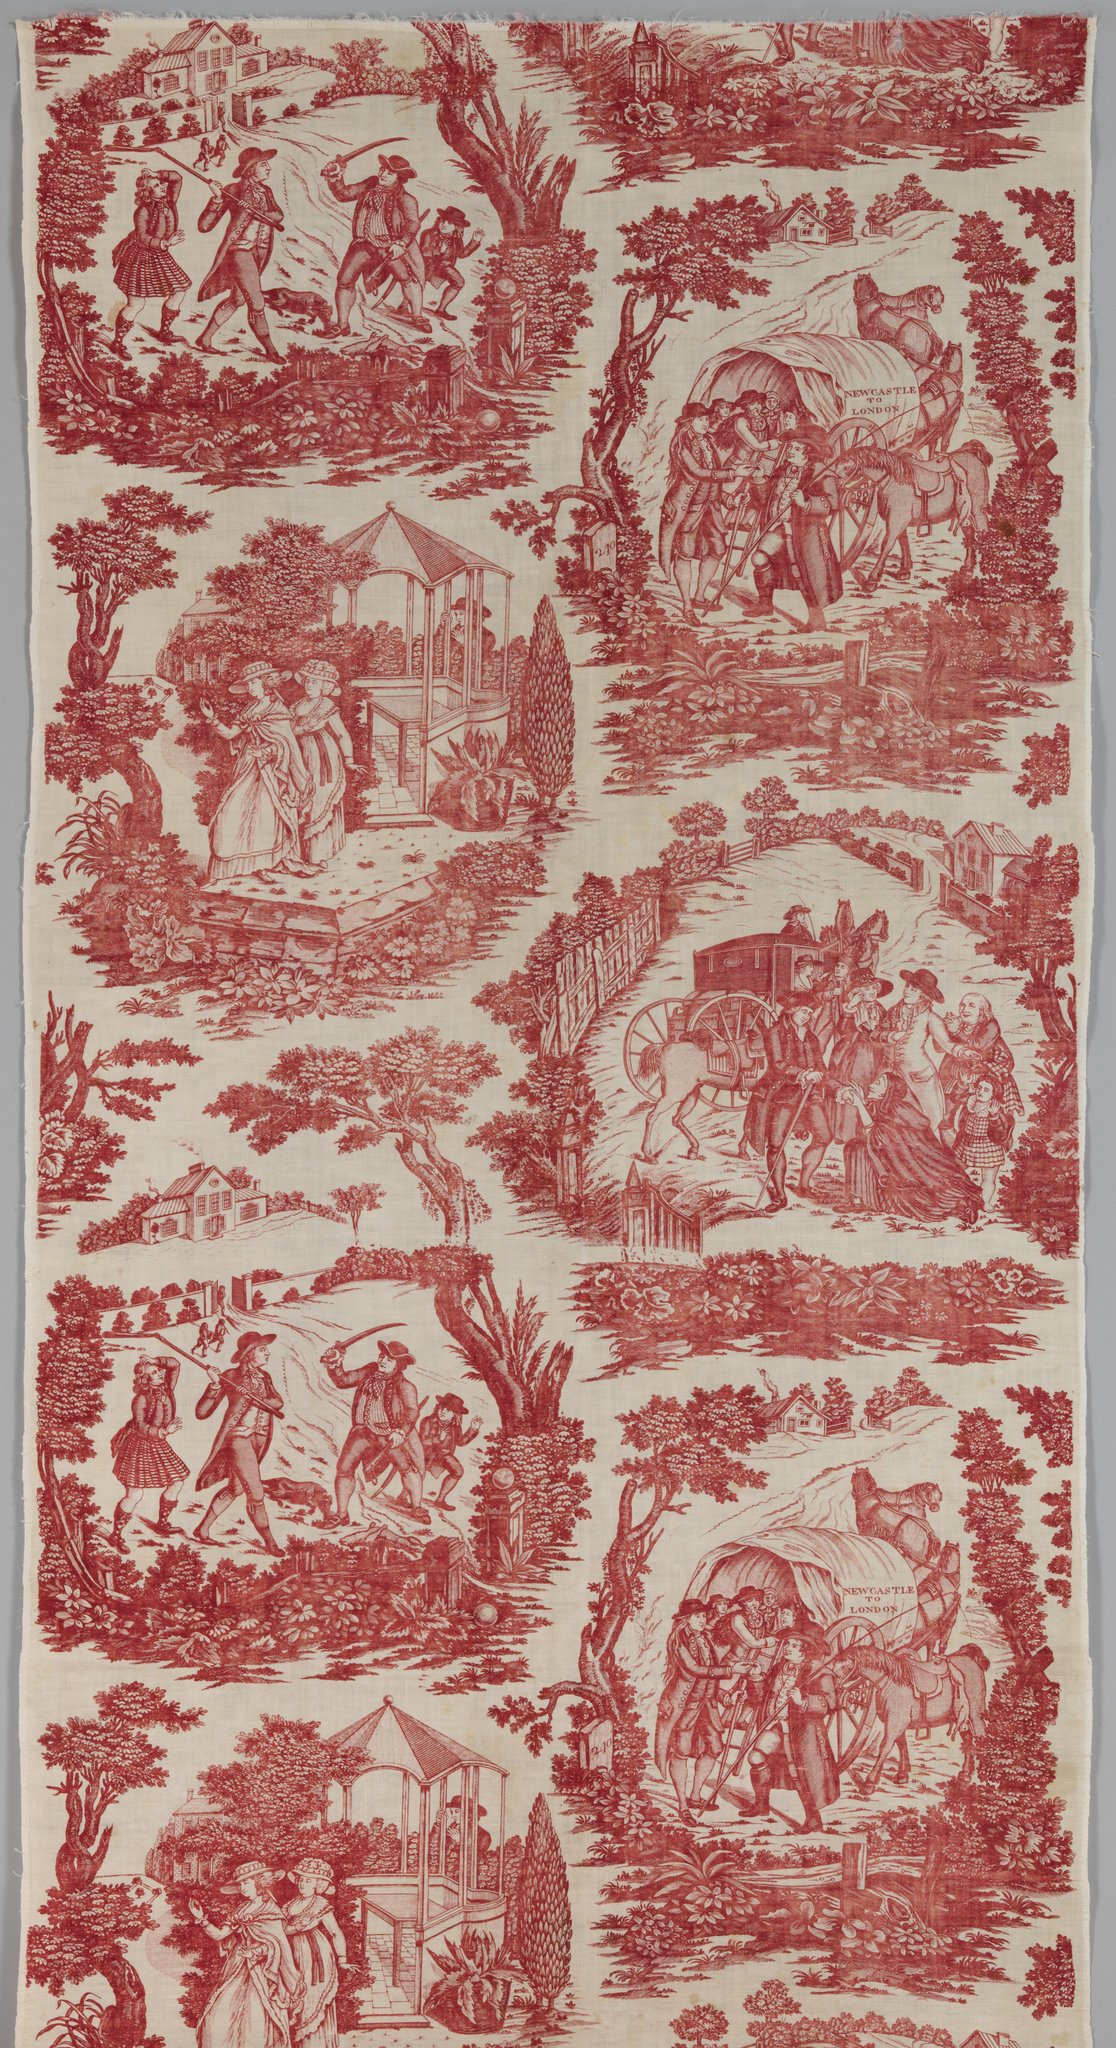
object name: breadth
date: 1790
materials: cotton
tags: men,women,trees,carriages